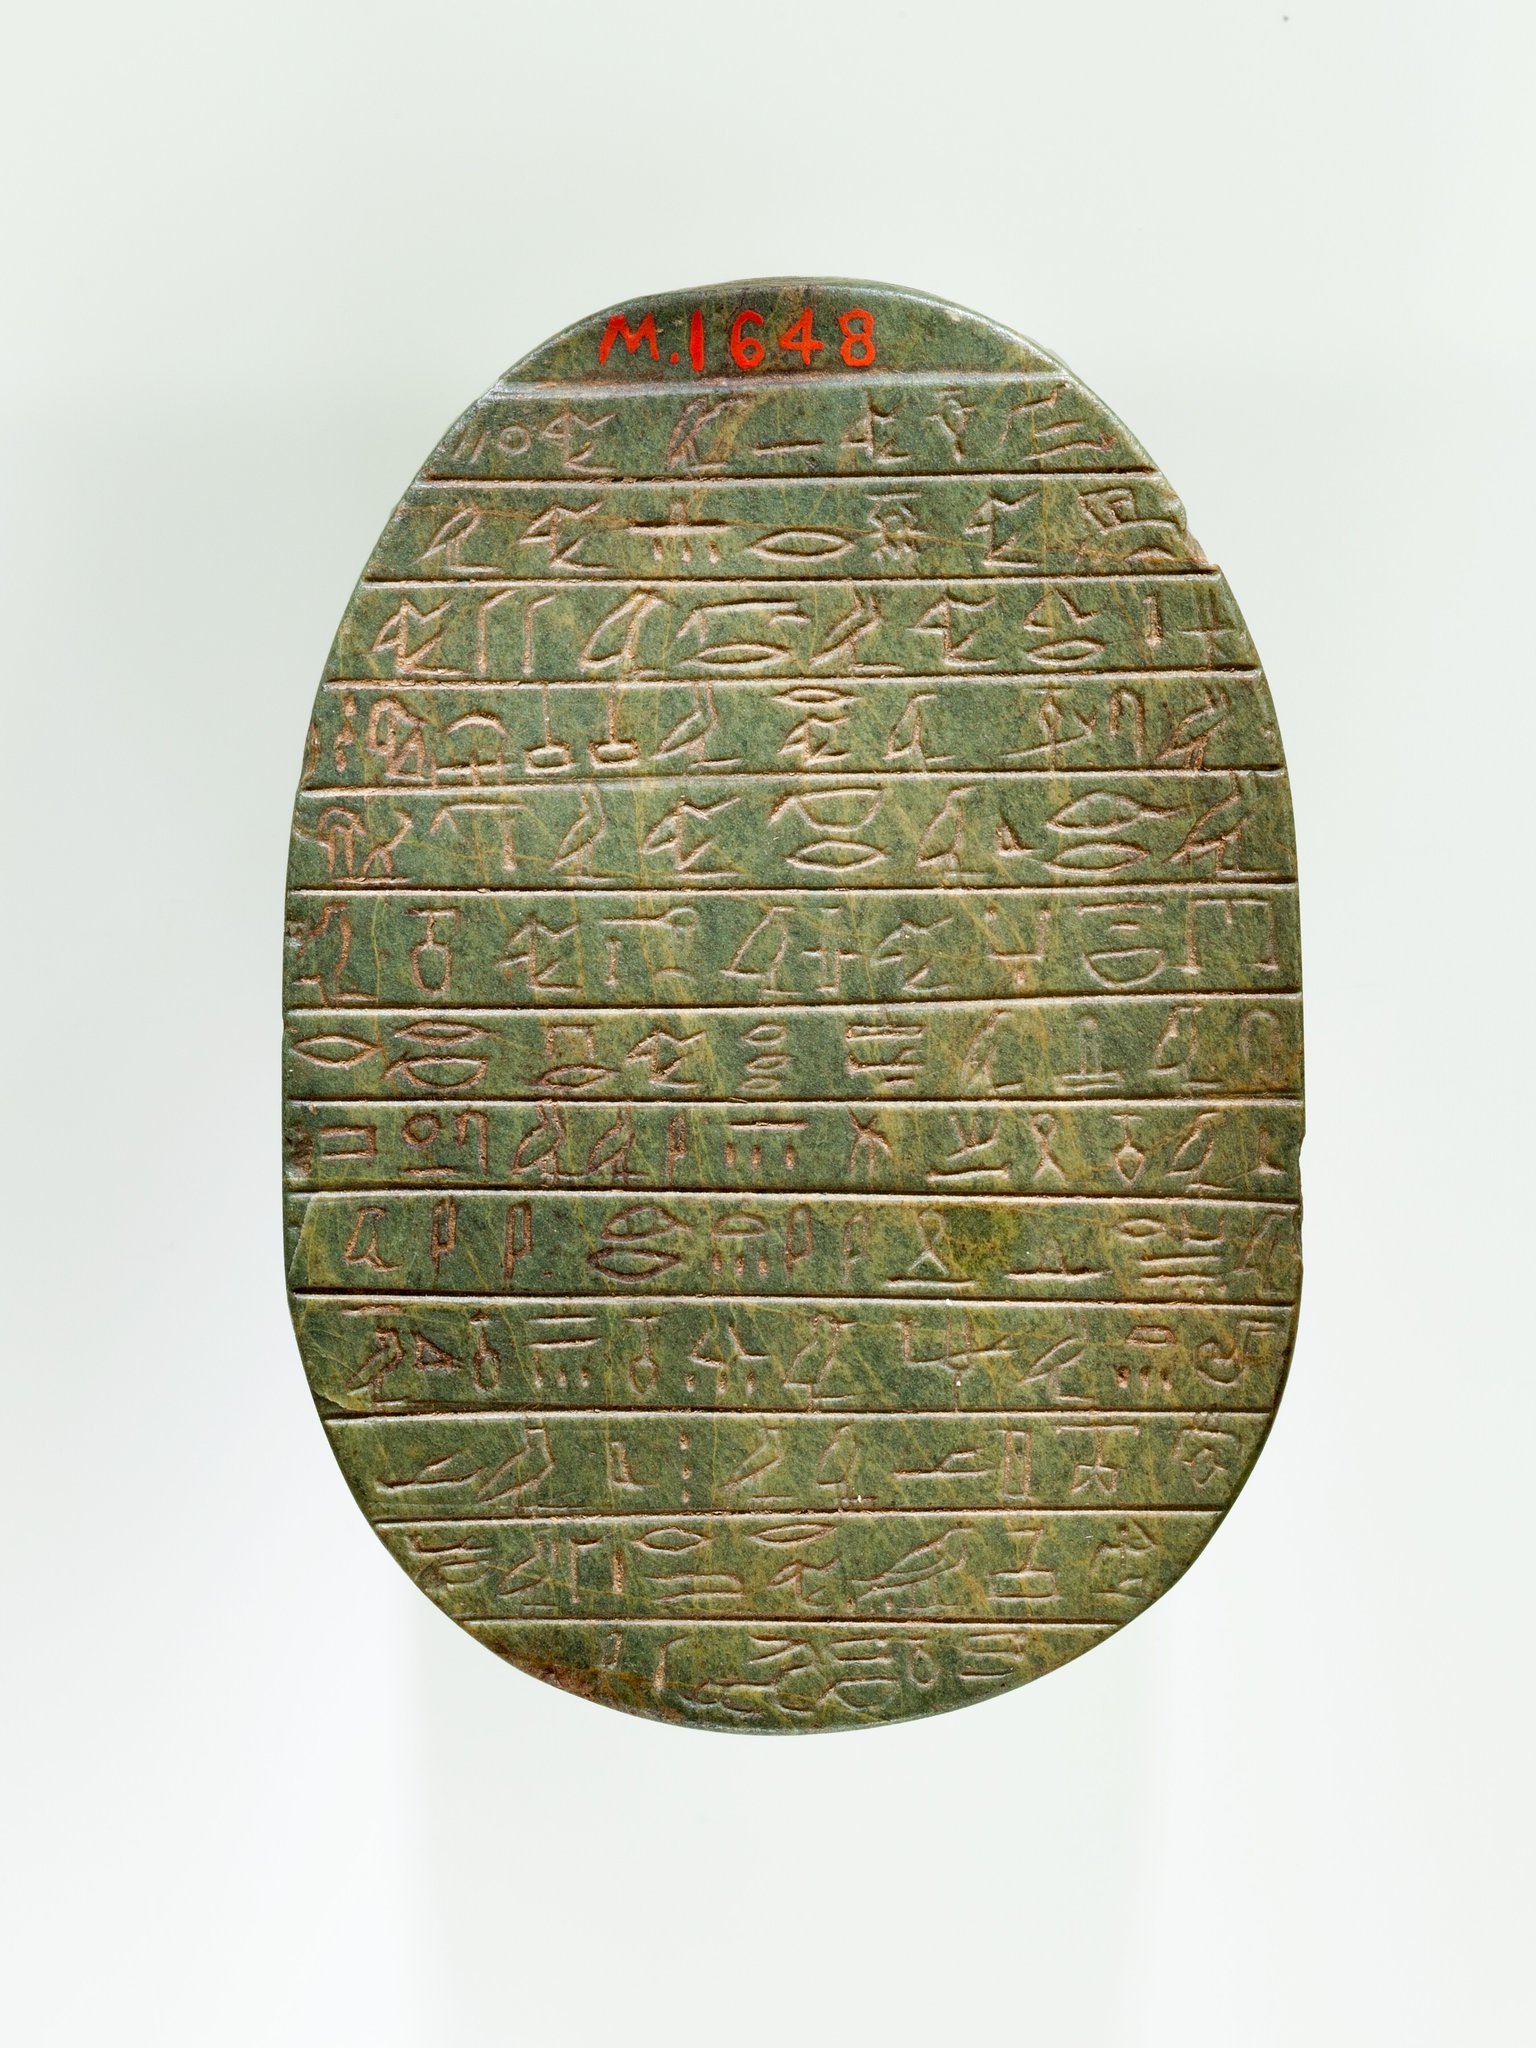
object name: scarab, name erased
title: Heart Scarab, Owner's Name Erased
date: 664-380 BCE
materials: stone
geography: egypt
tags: hieroglyphs,scarabs